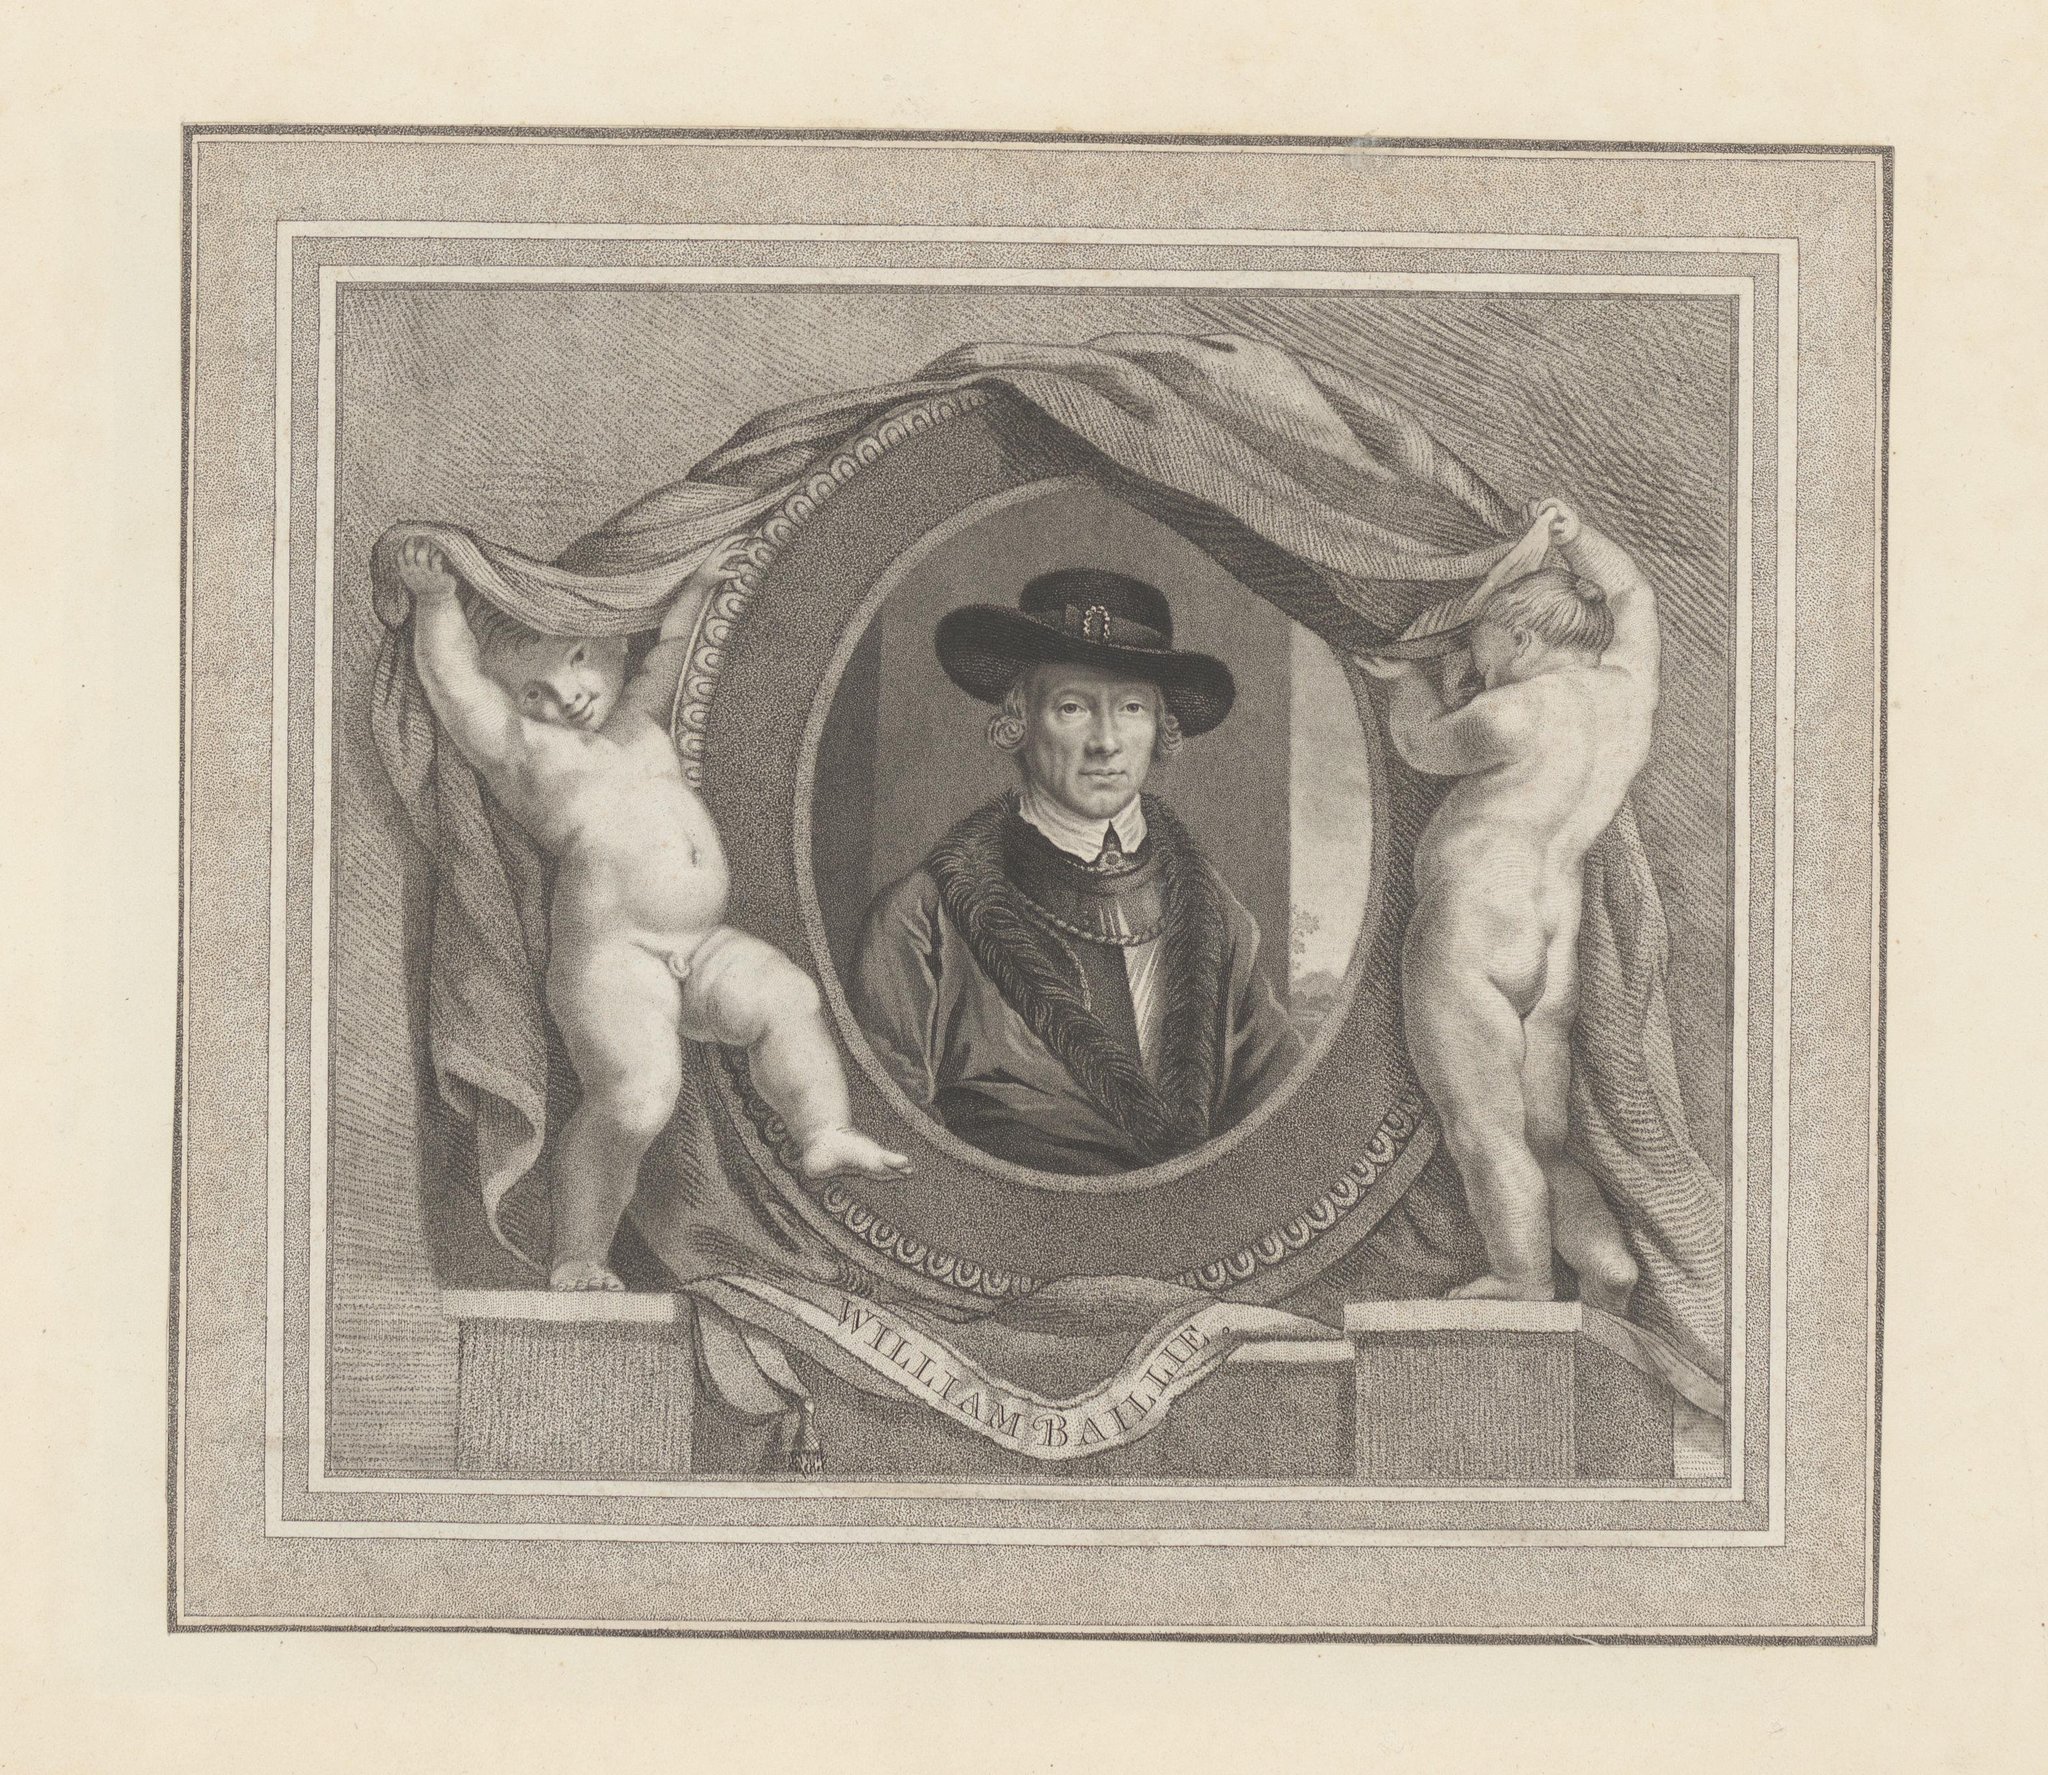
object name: album leaf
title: Portret van William Baillie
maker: william baillie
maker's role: print maker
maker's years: 1723-1810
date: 1753-1810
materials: paper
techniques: etching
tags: print maker, william baillie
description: Twee putti onthullen een portret van William Baillie. De prent maakt deel uit van een album.